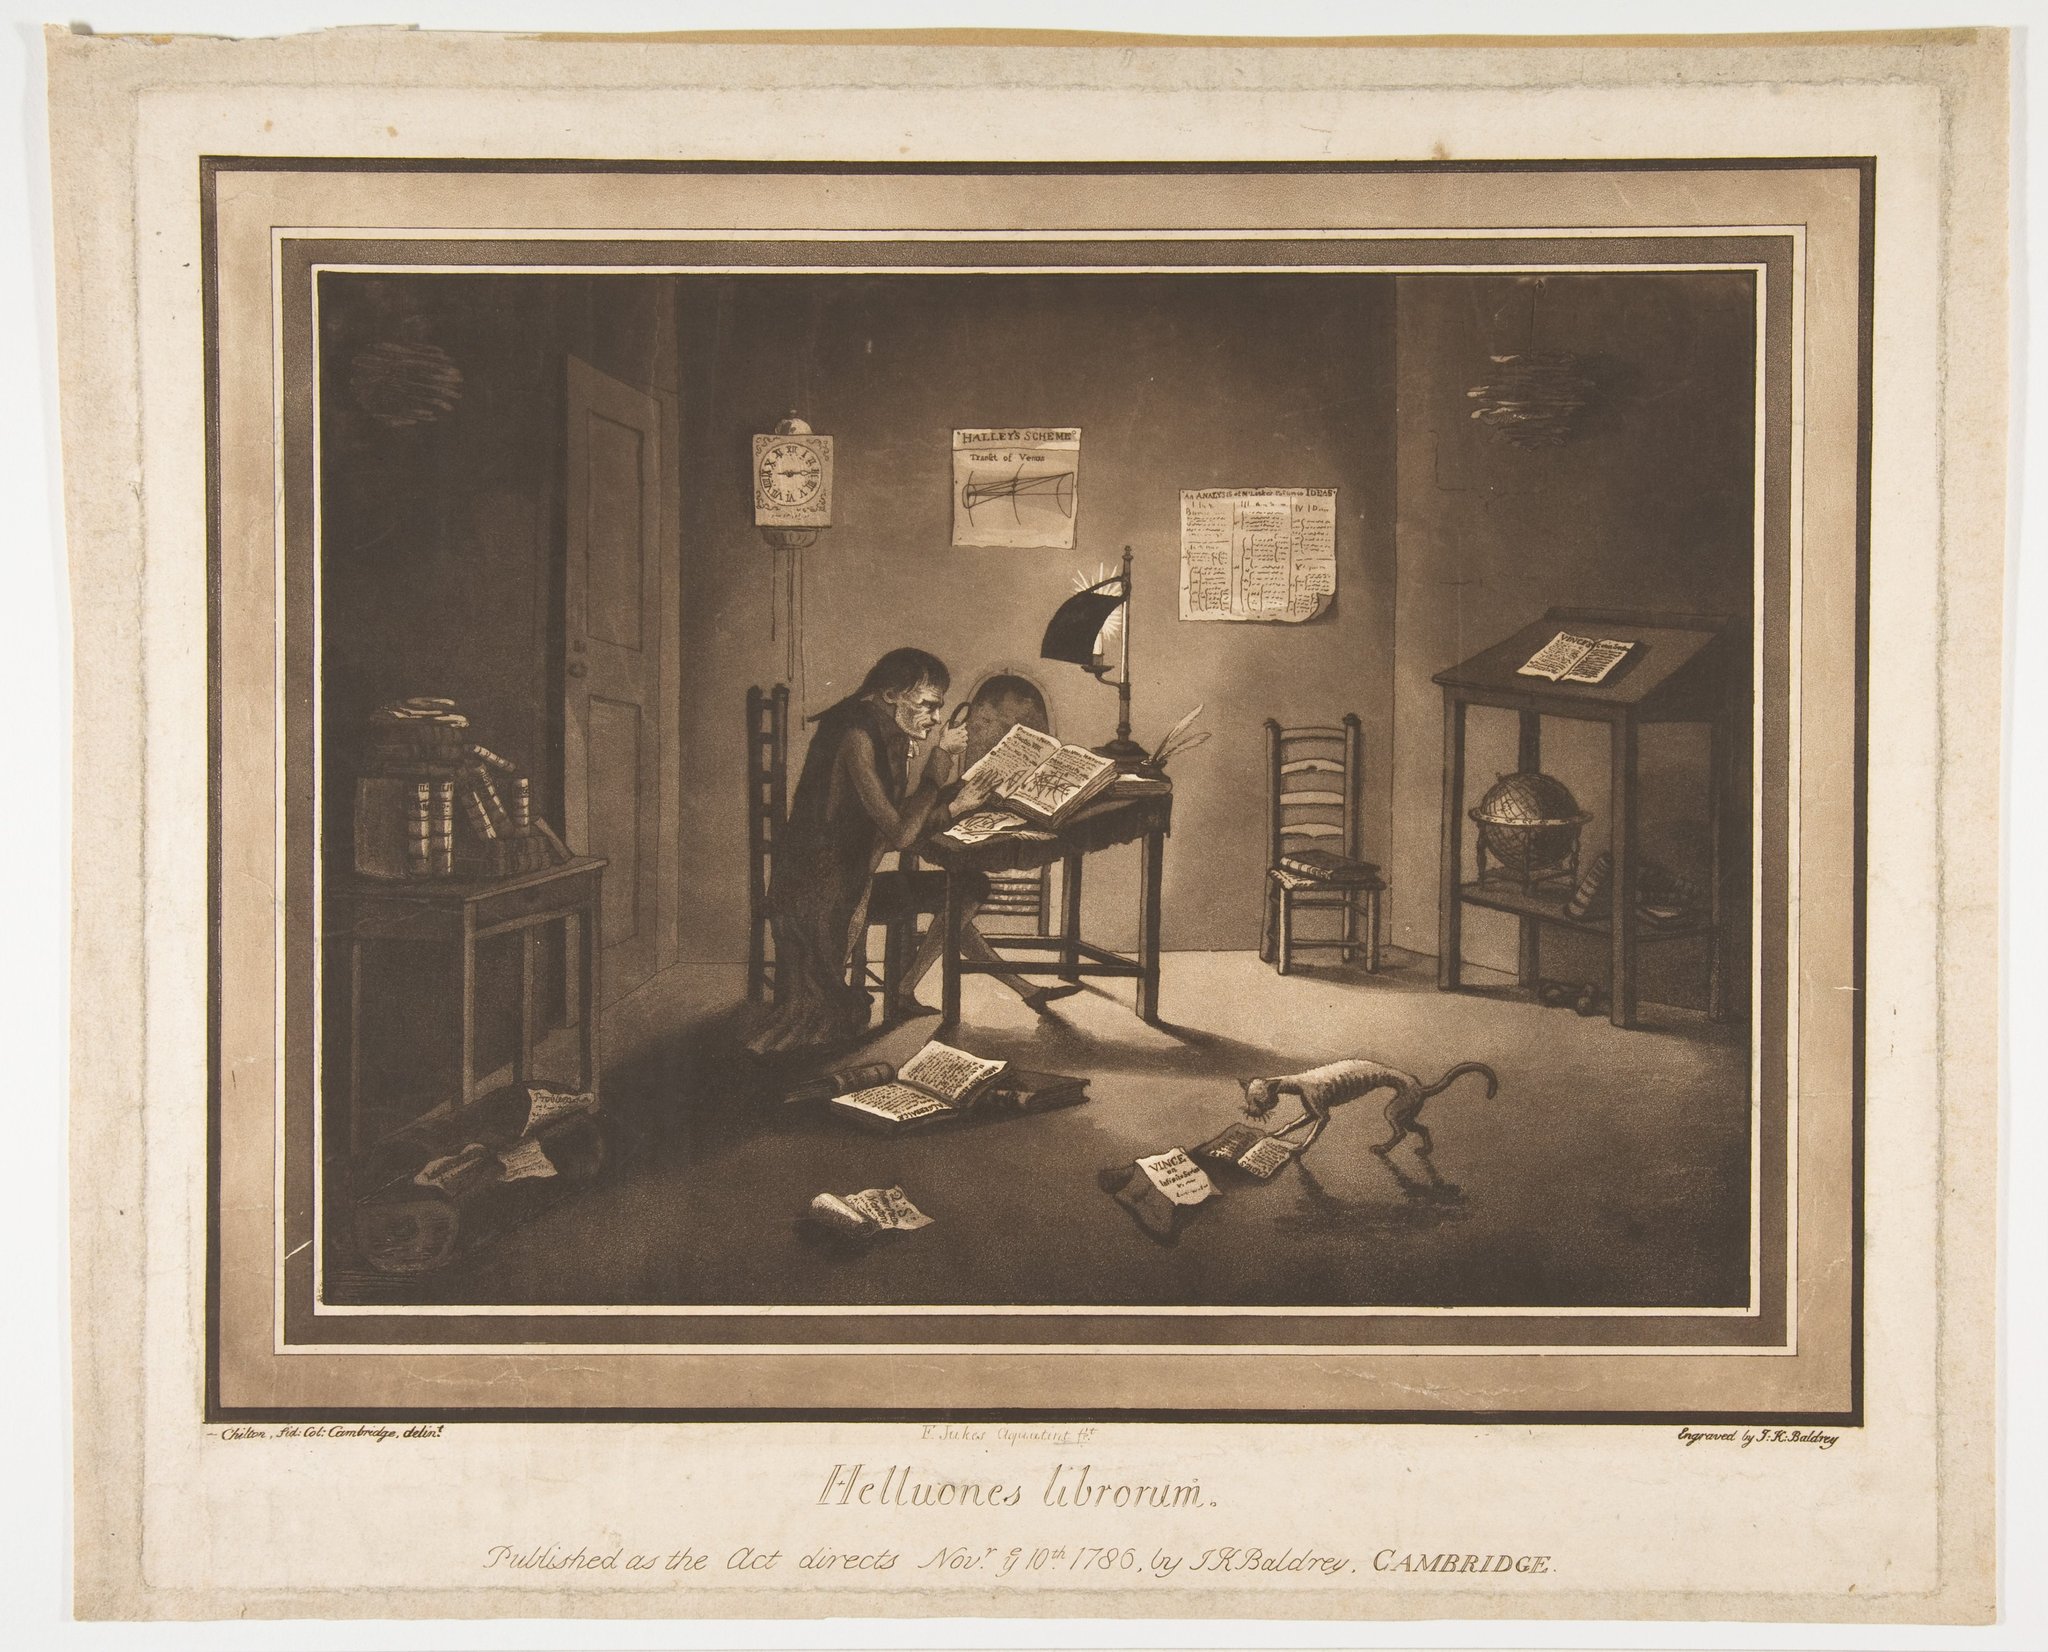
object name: print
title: Helluones librorum (Bookworms)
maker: joshua kirby baldrey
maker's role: artist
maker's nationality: british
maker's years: 1754-1828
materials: ink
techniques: aquatint, printing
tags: books,interiors,men,reading,cats,desks,chairs